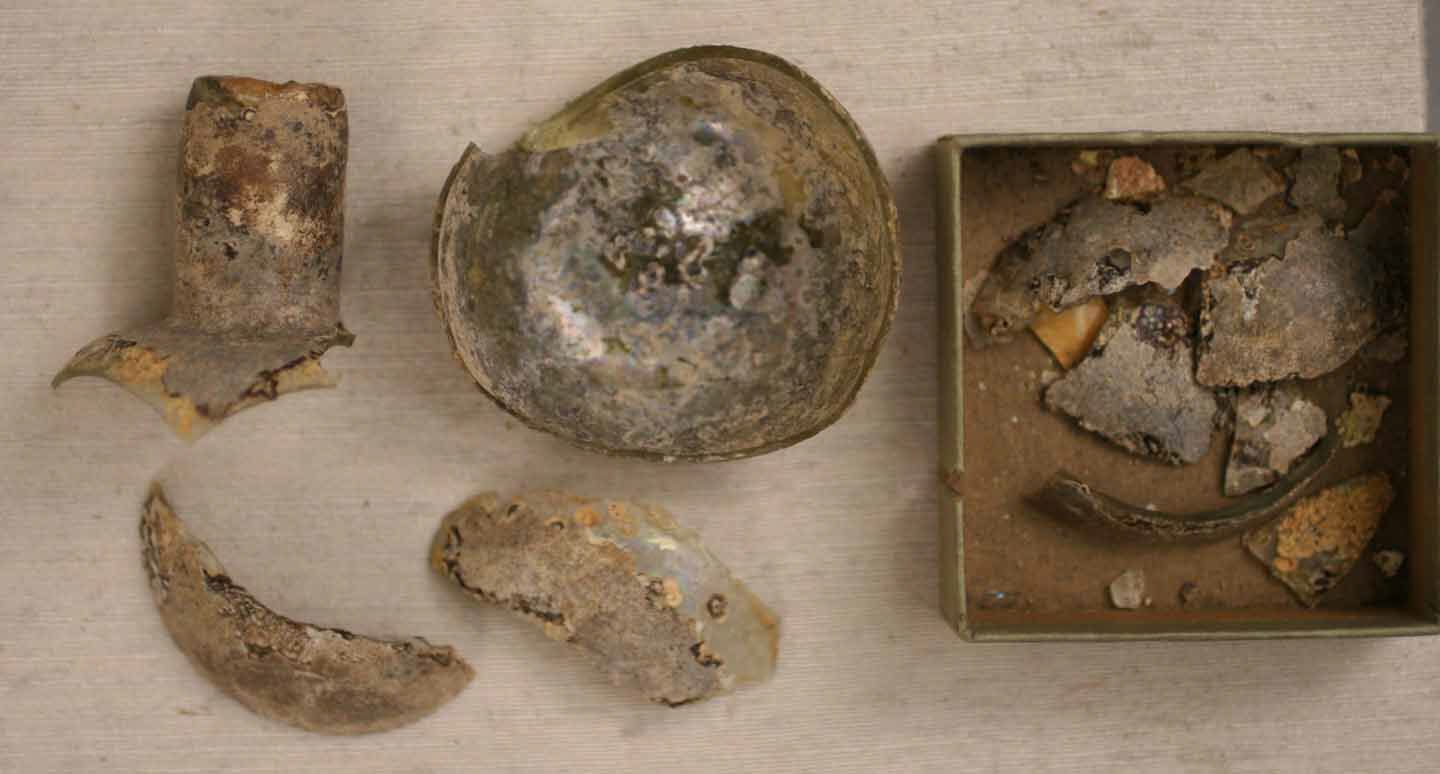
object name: fragmentary bottle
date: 201-700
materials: glass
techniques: glassblowing, tooling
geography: iraq